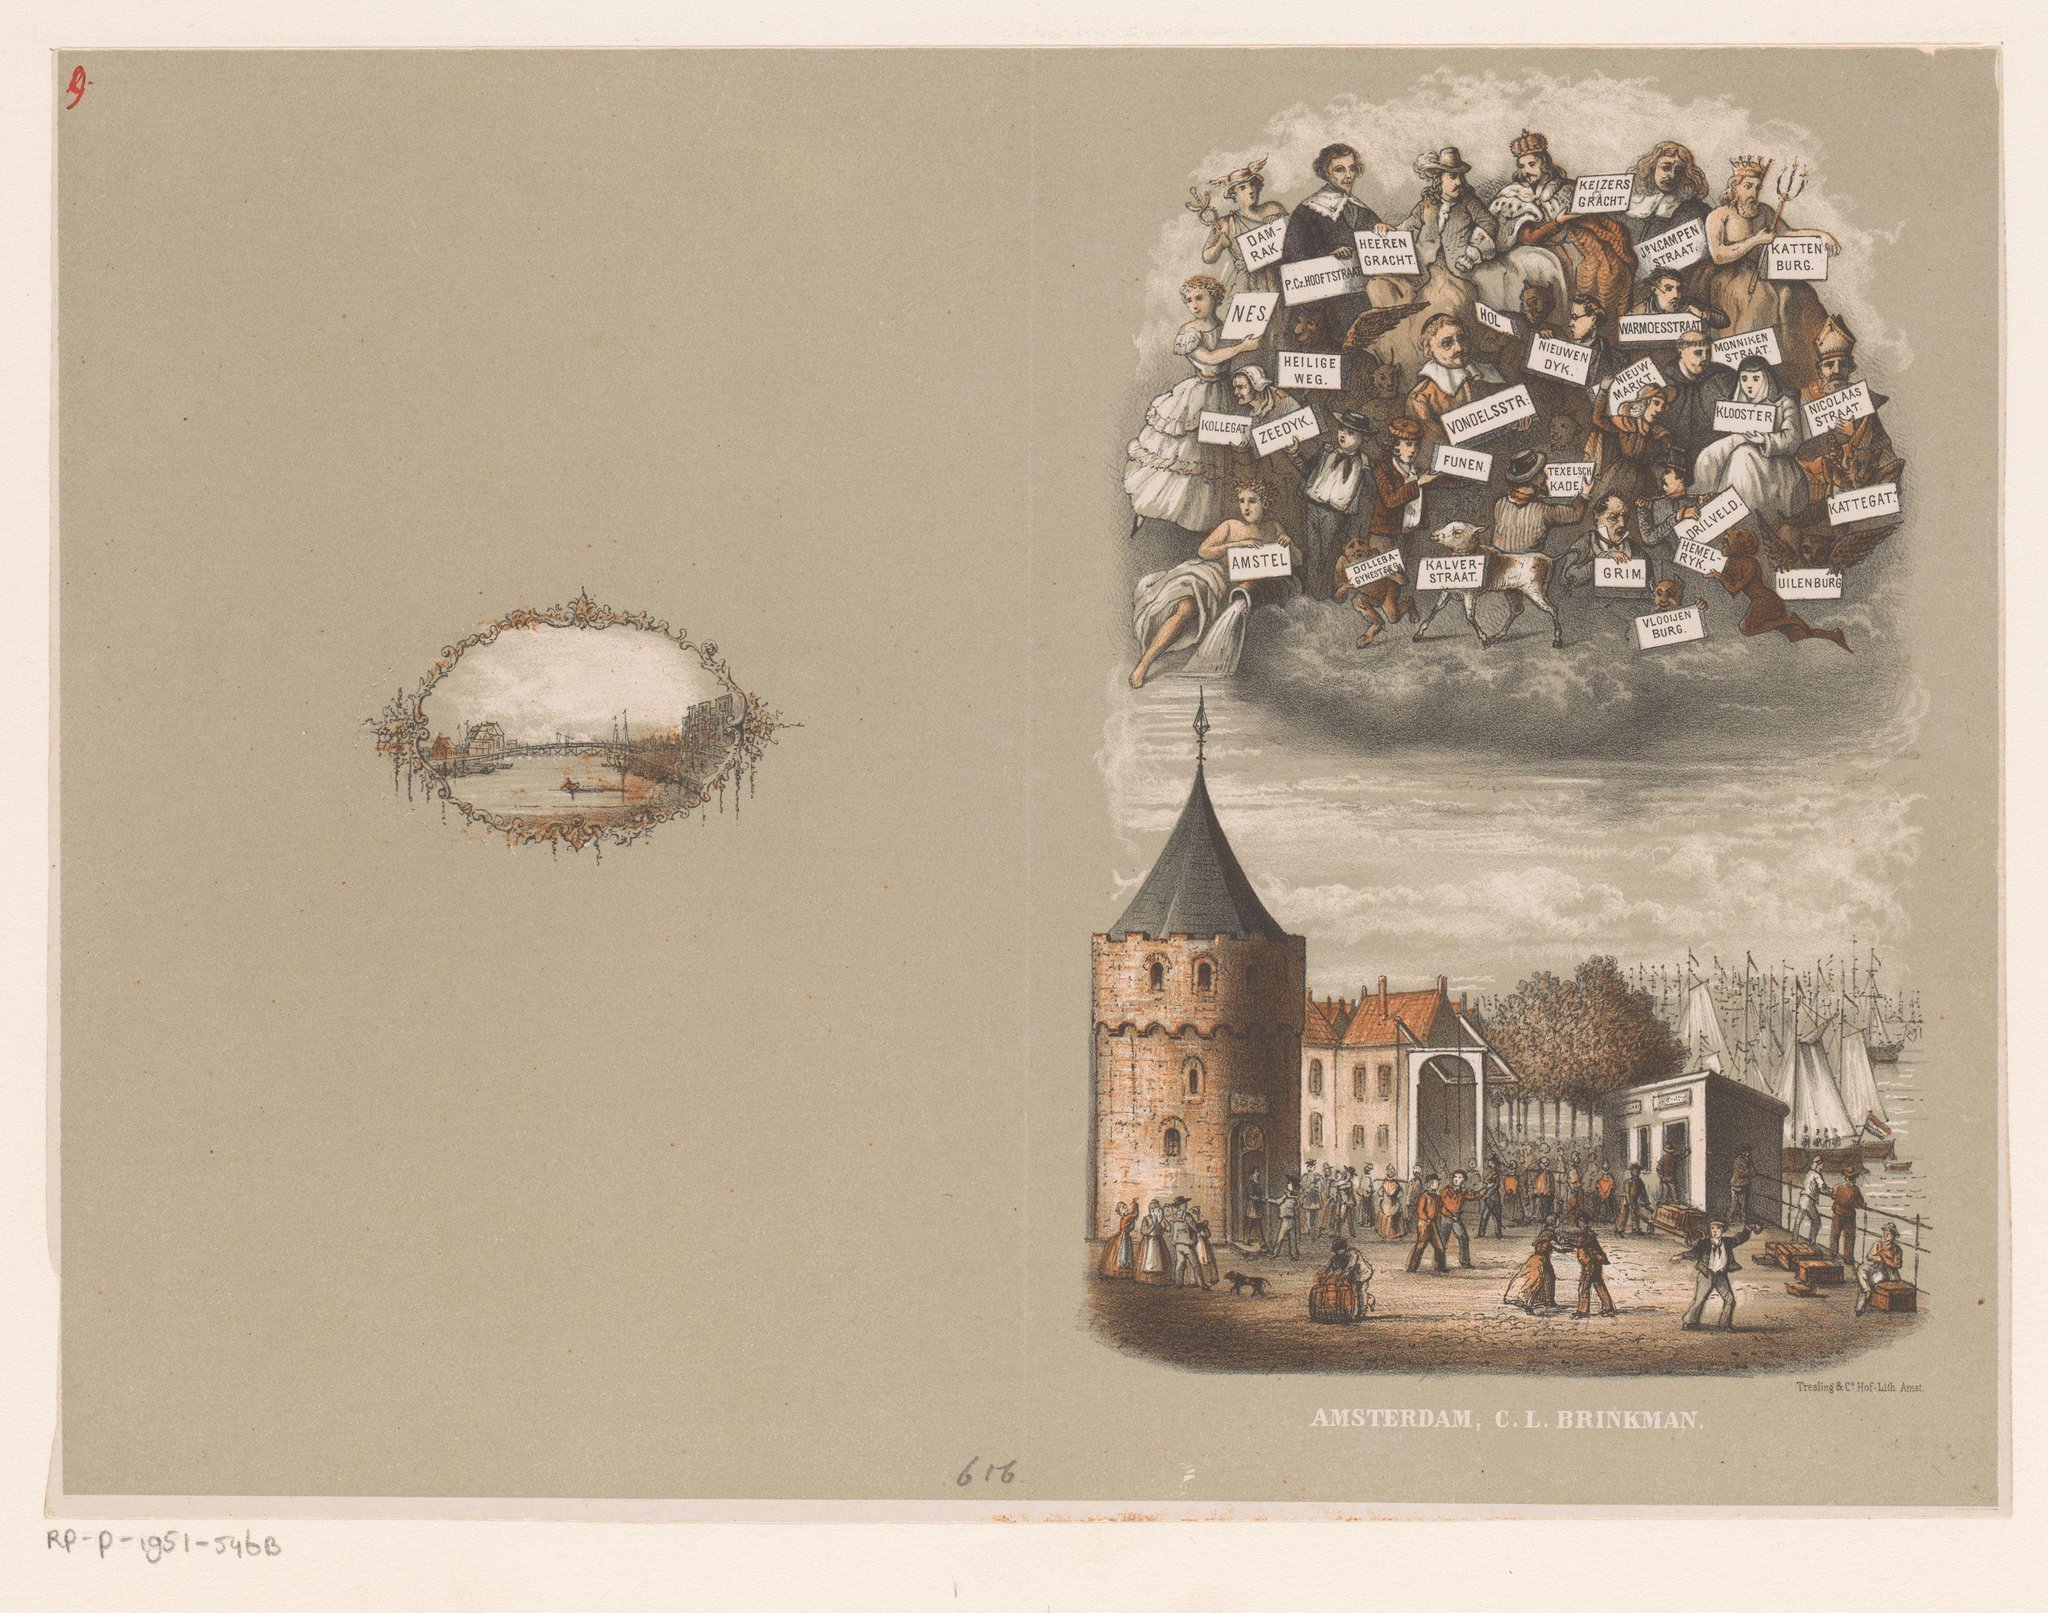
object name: print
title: Omslag voor: Amsterdam. Oorsprong en afleiding van de namen der grachten, eilanden, pleinen, straten, stegen, bruggen, sluizen en torens dezer stad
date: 1865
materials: paper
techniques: tone lithography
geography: amsterdam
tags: city-view in general; 'veduta', amsterdam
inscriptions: collector's mark: Lugt 2228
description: Onderin de Schreierstoren in Amsterdam. Op straat een menigte. Bovenin verschillende historische figuren en types met borden die verwijzen naar plaatsen in Amsterdam. Links een vignet met gezicht op een rivier met brug.